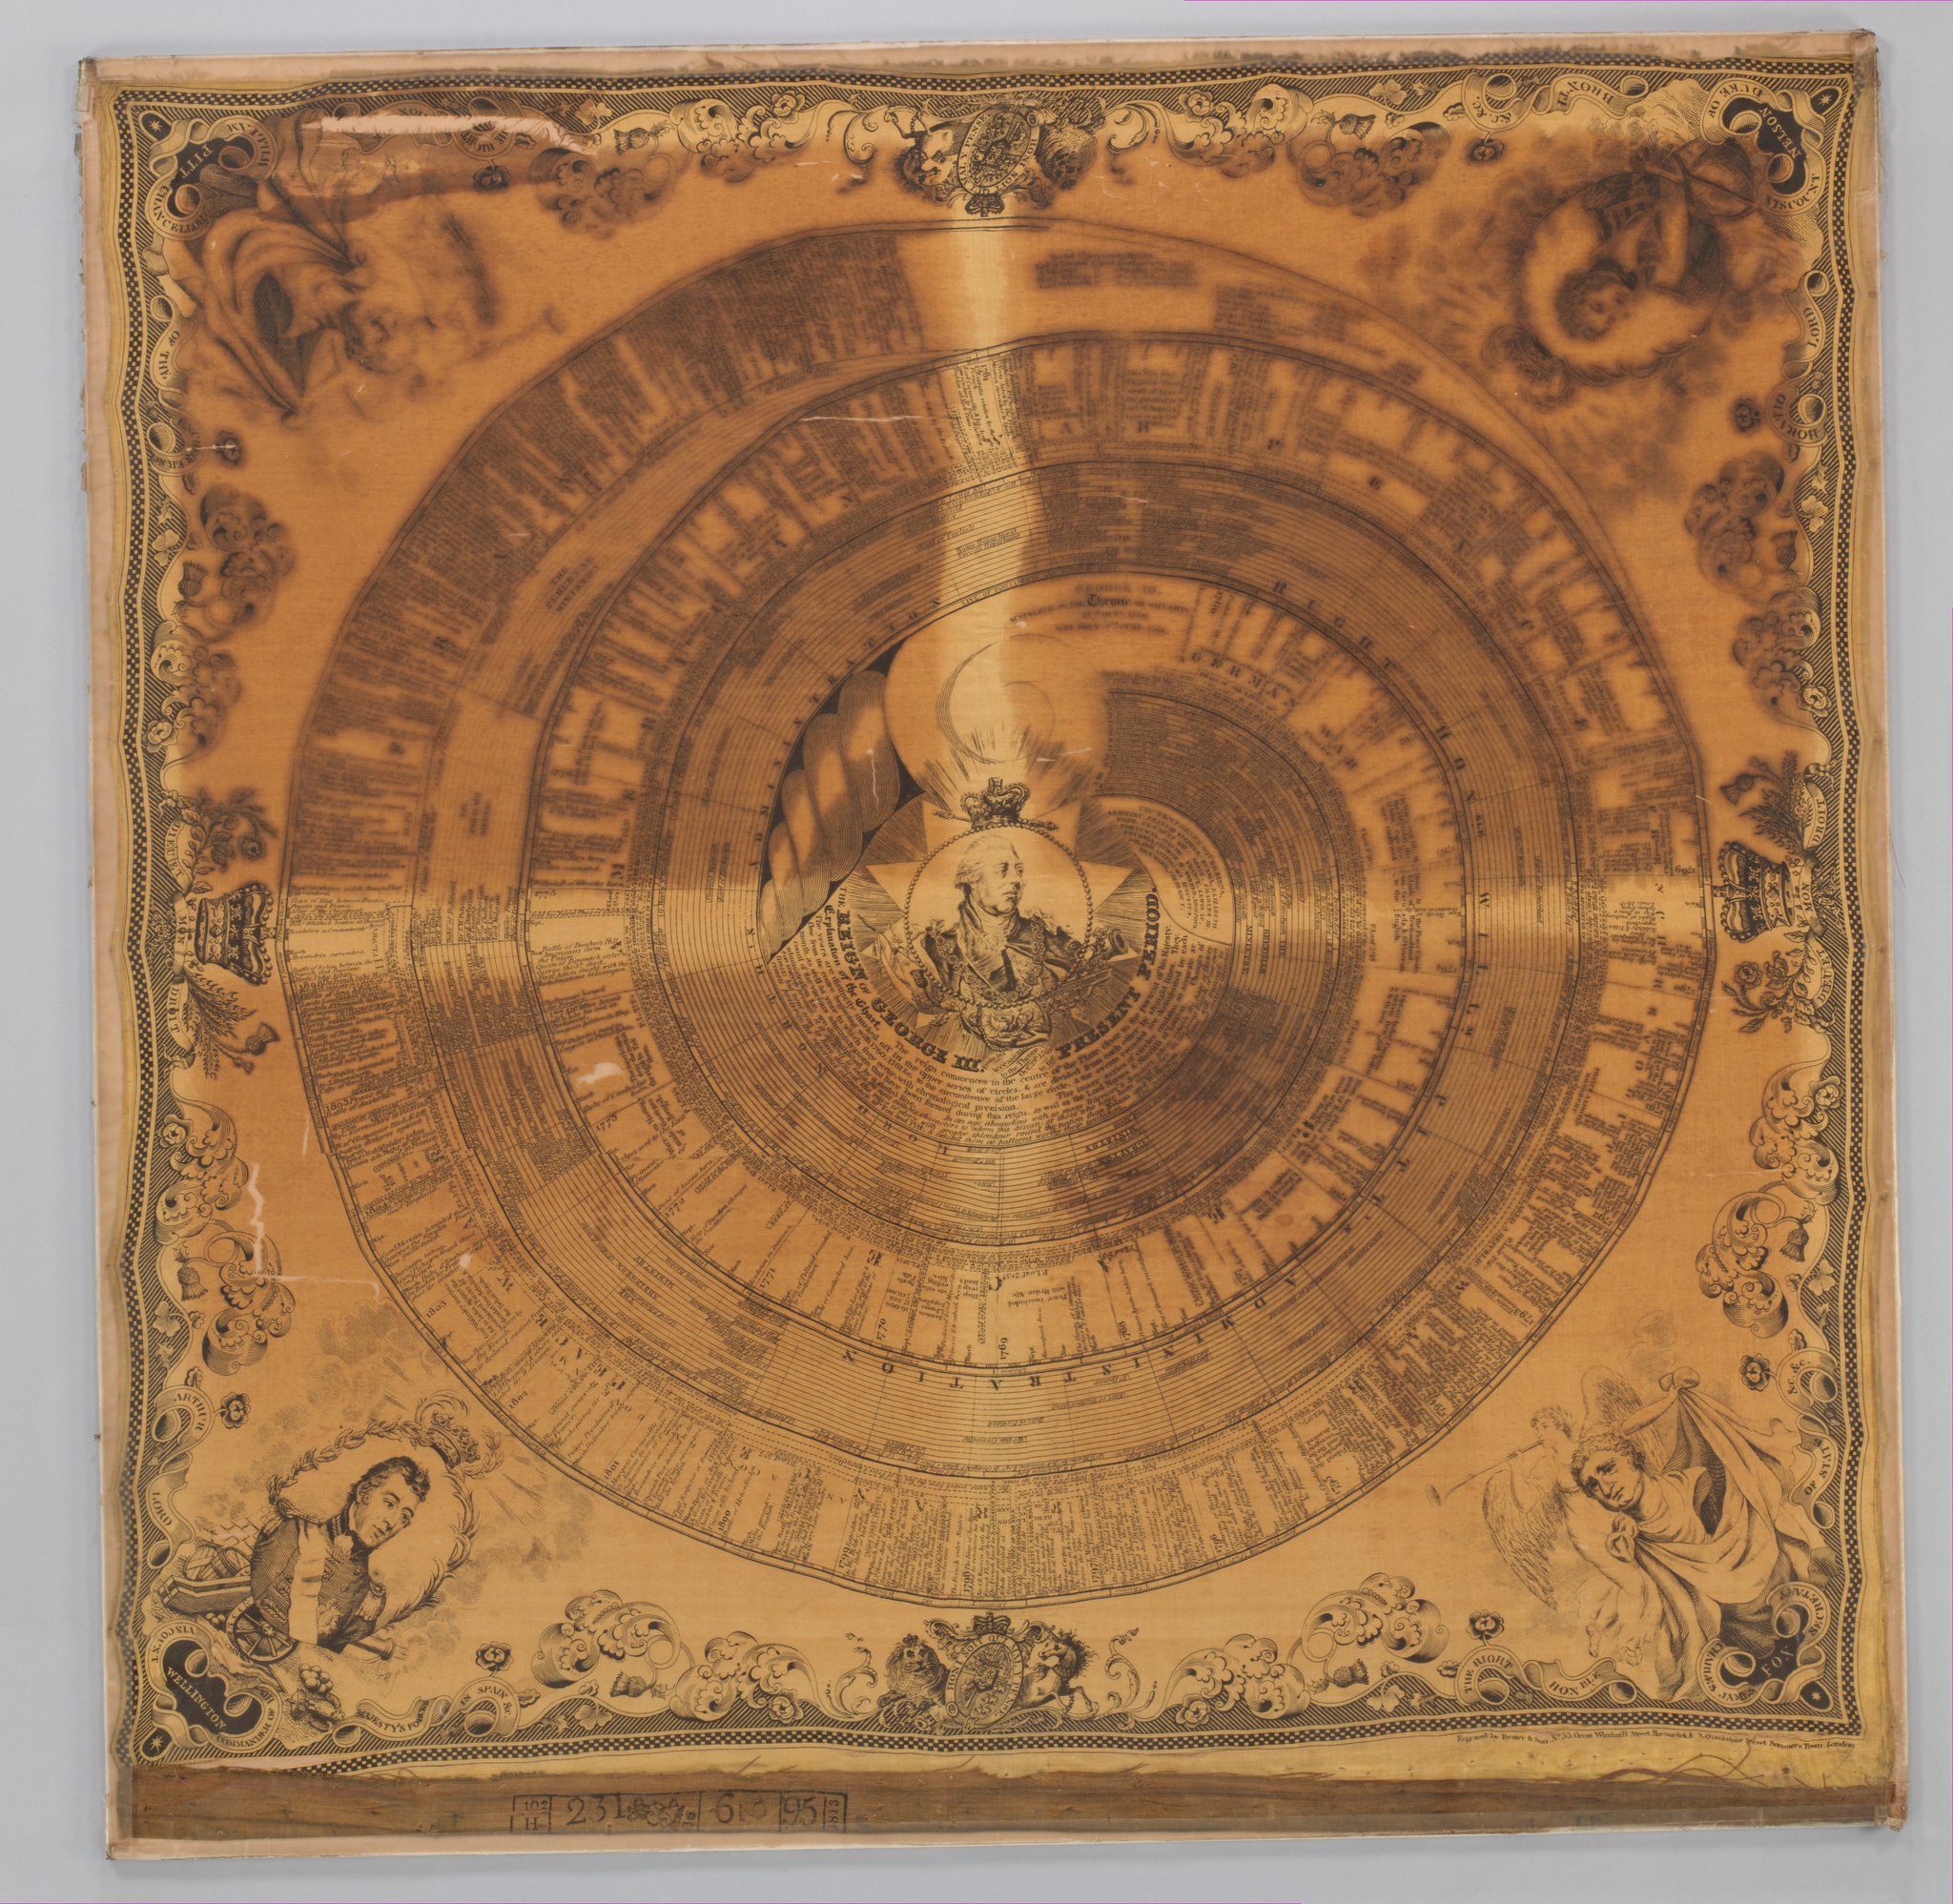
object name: handkerchief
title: Event handkerchief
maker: rymer & son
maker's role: engraver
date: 1813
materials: silk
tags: kings,men,george iii